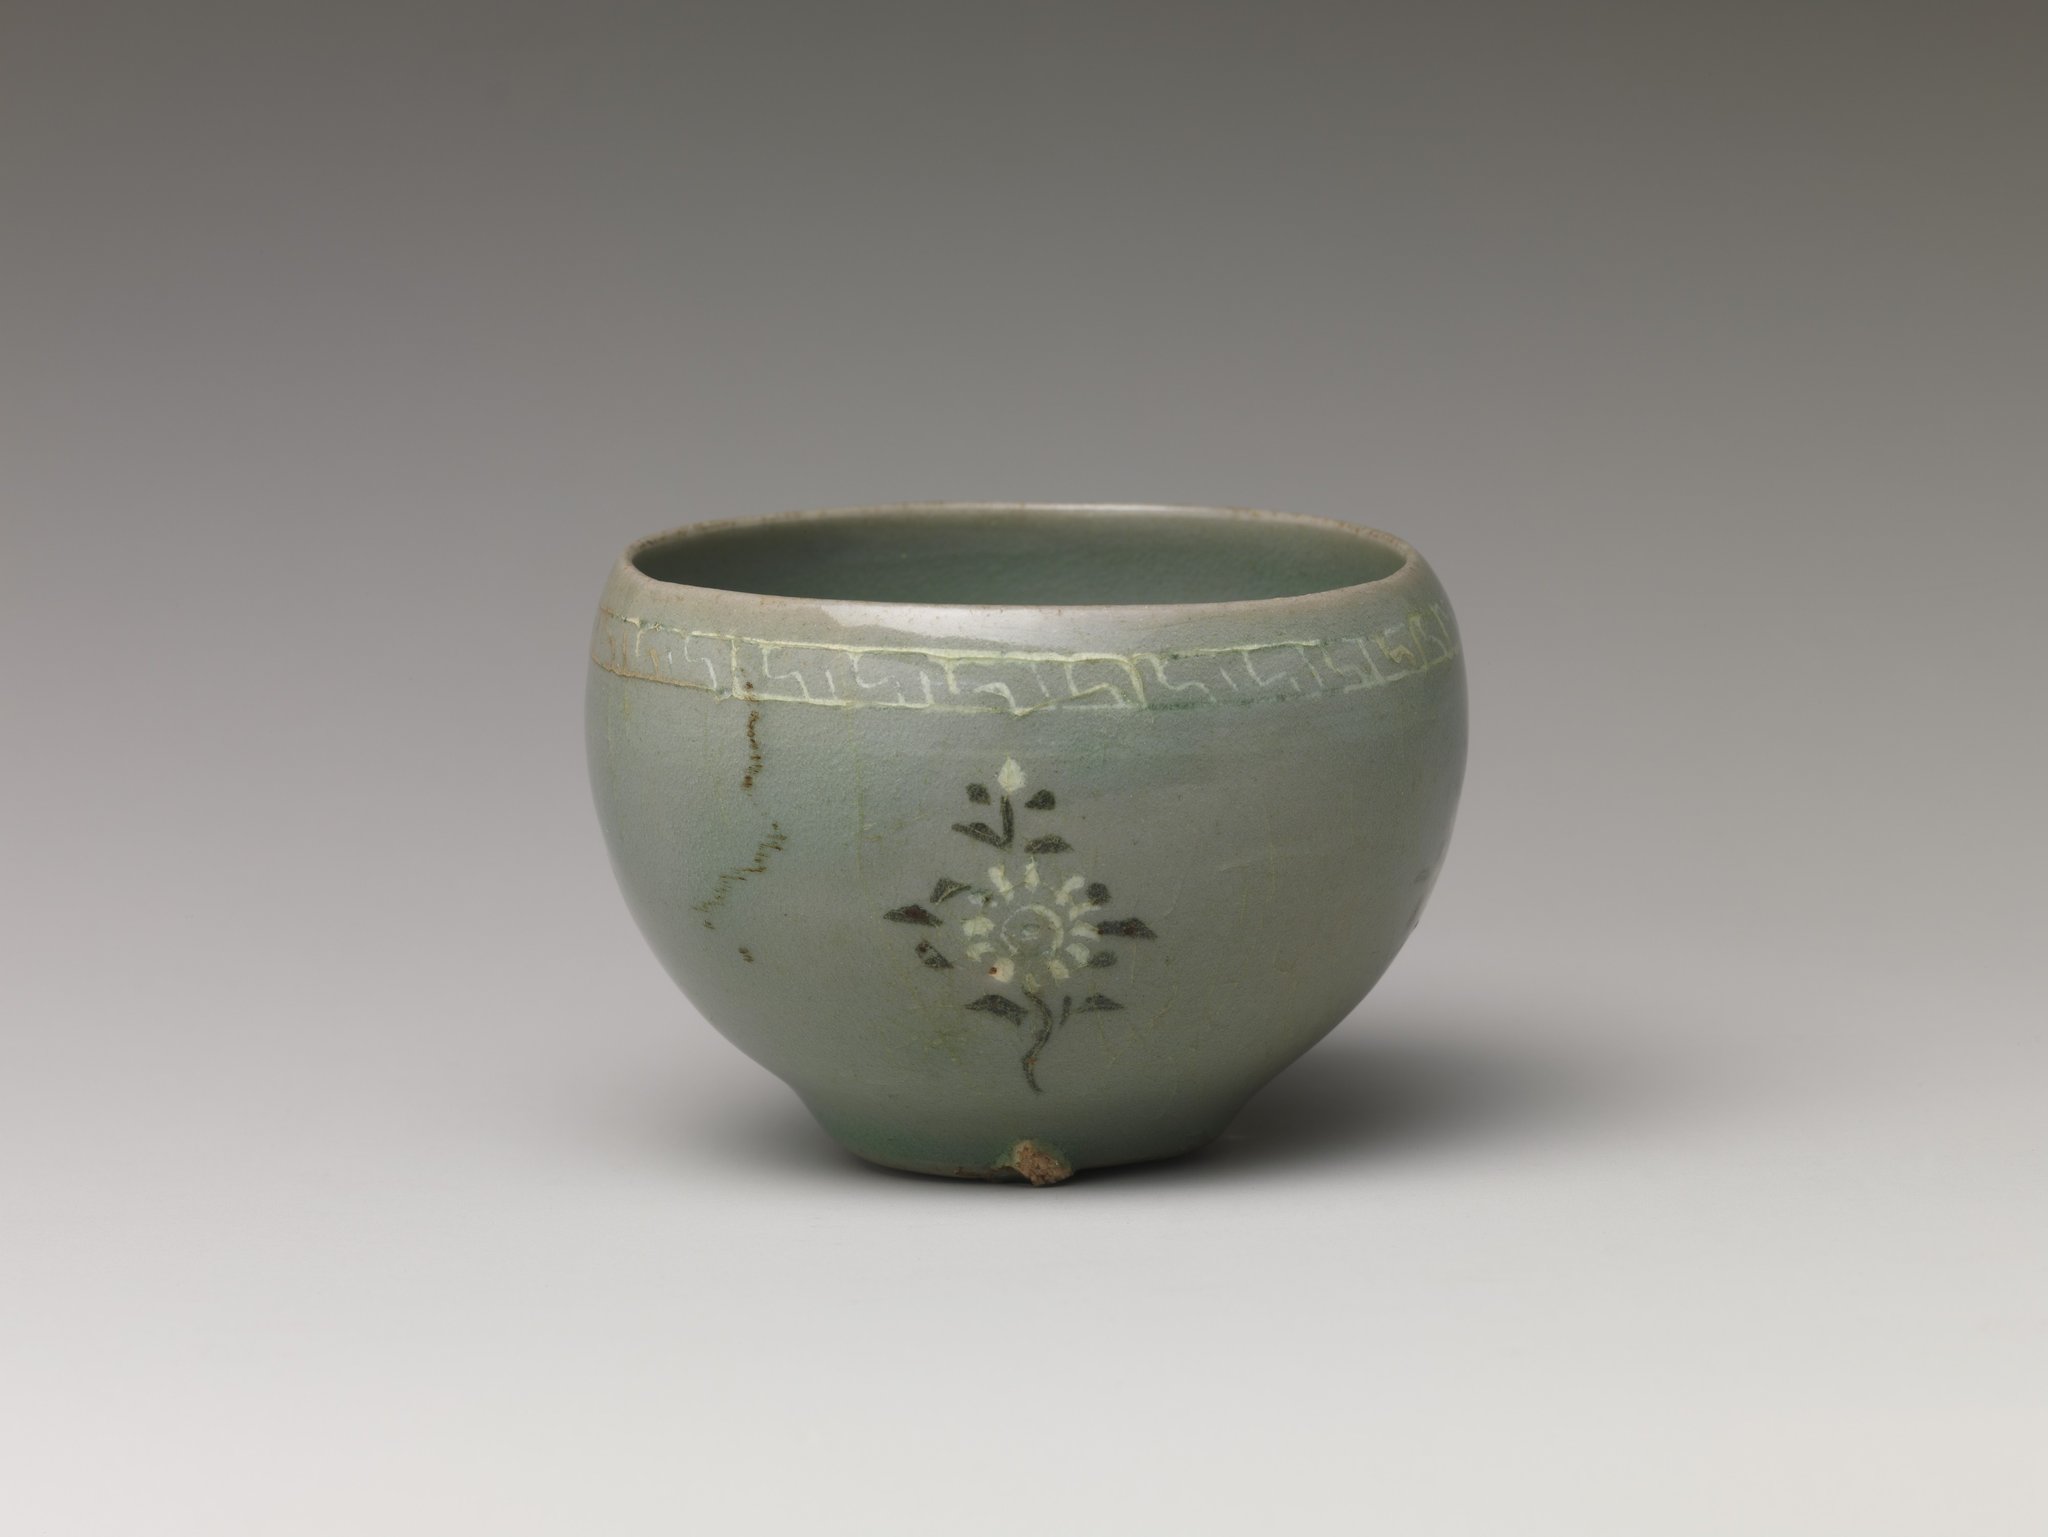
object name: cup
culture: korean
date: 1134-1166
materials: ceramic glaze, glaze, stoneware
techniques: inlay